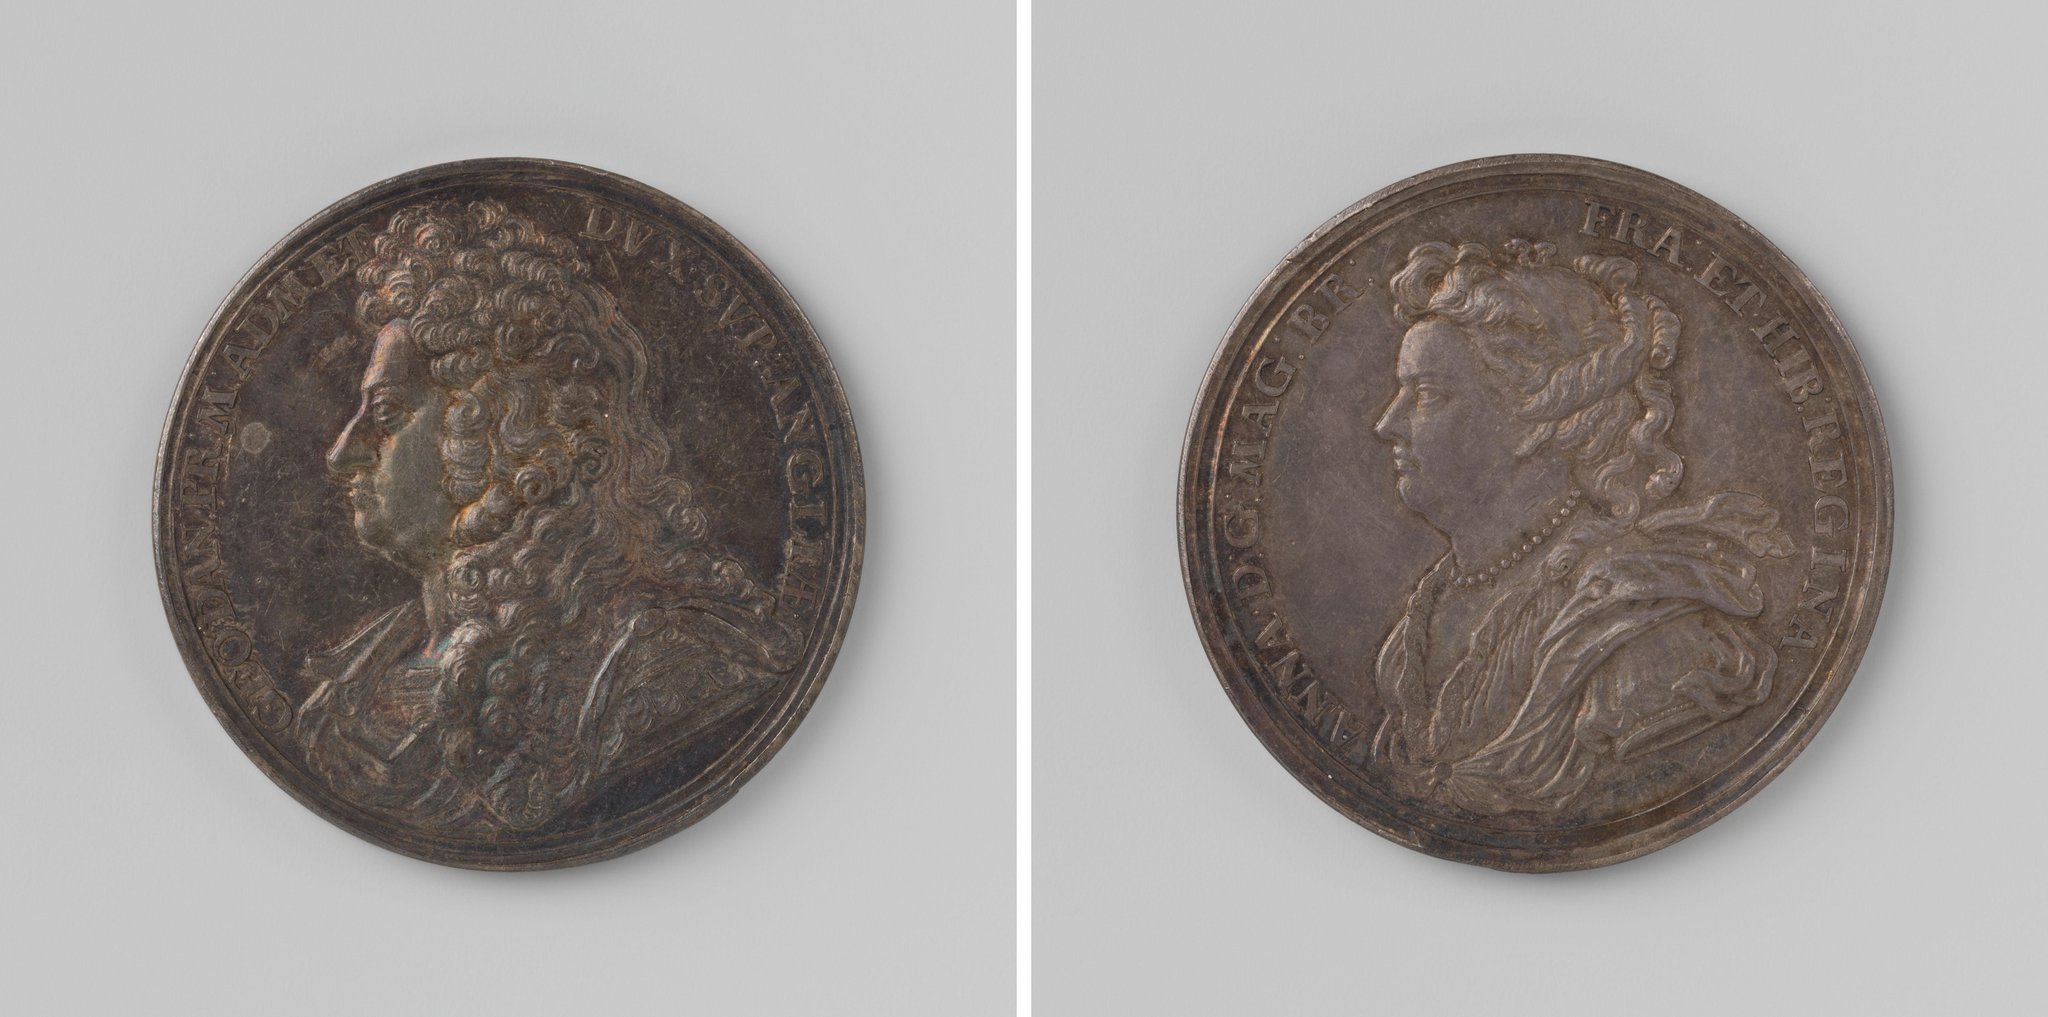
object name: history medal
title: Prins George van Denemarken benoemd tot opperbevelhebber van de Britse krijgsmacht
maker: john croker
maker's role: die cutter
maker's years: 1670-1741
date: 1702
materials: silver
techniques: striking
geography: london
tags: george (prins van denemarken), anna stuart (koningin van engeland en schotland)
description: Zilveren penning. Voorzijde: borststuk vrouw binnen omschrift. Keerzijde: borststuk man binnen omschrift.